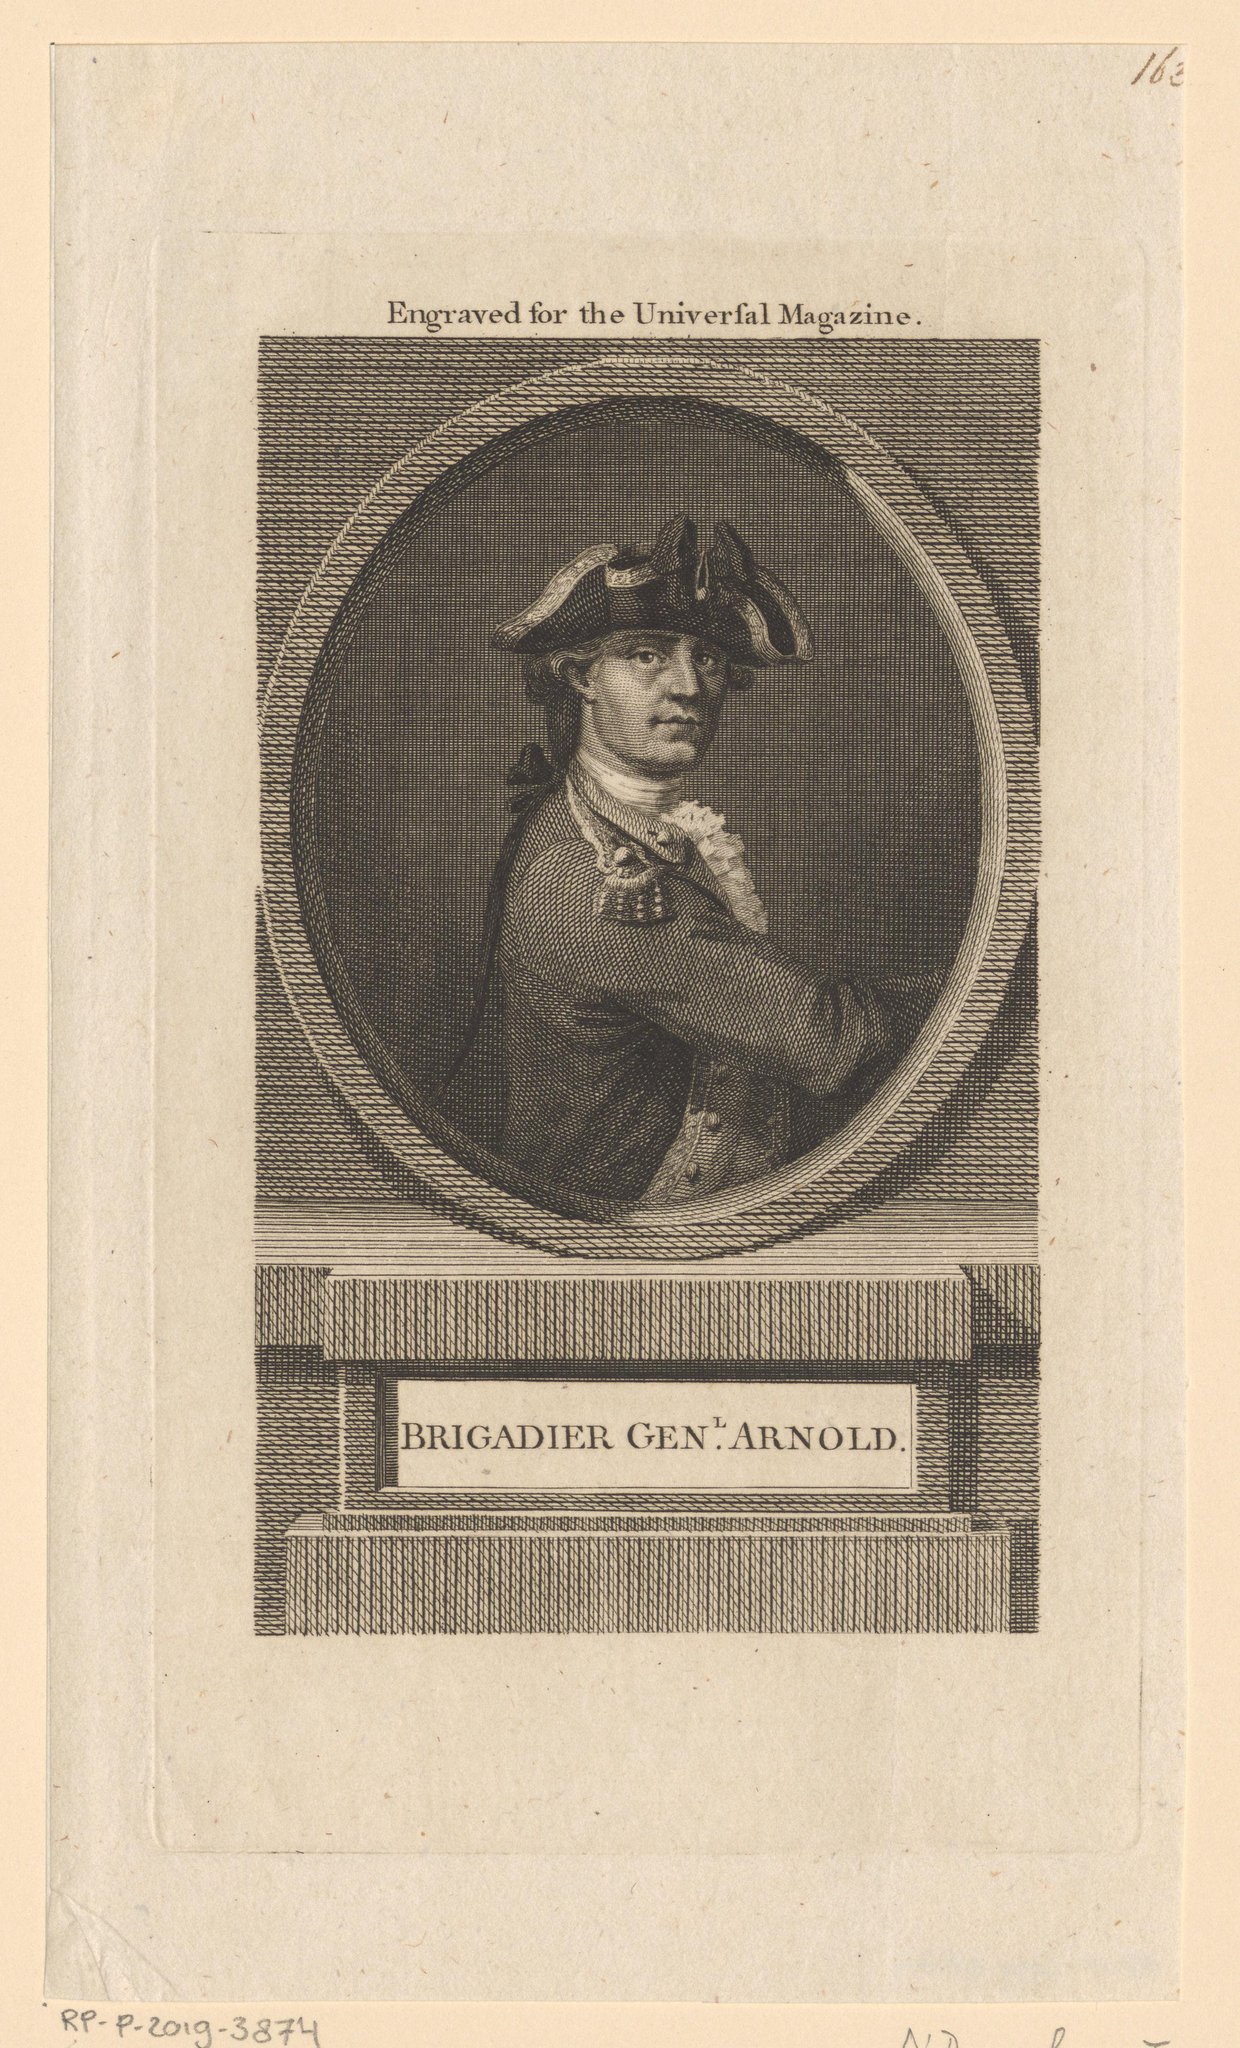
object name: print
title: Portret van Benedict Arnold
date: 1781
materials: paper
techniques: engraving, etching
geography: london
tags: historical persons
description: Prent uit: The Universal Magazine of Knowledge and Pleasure. Londen: Stephen Austen Cumberlege, 1781, dl. 69.